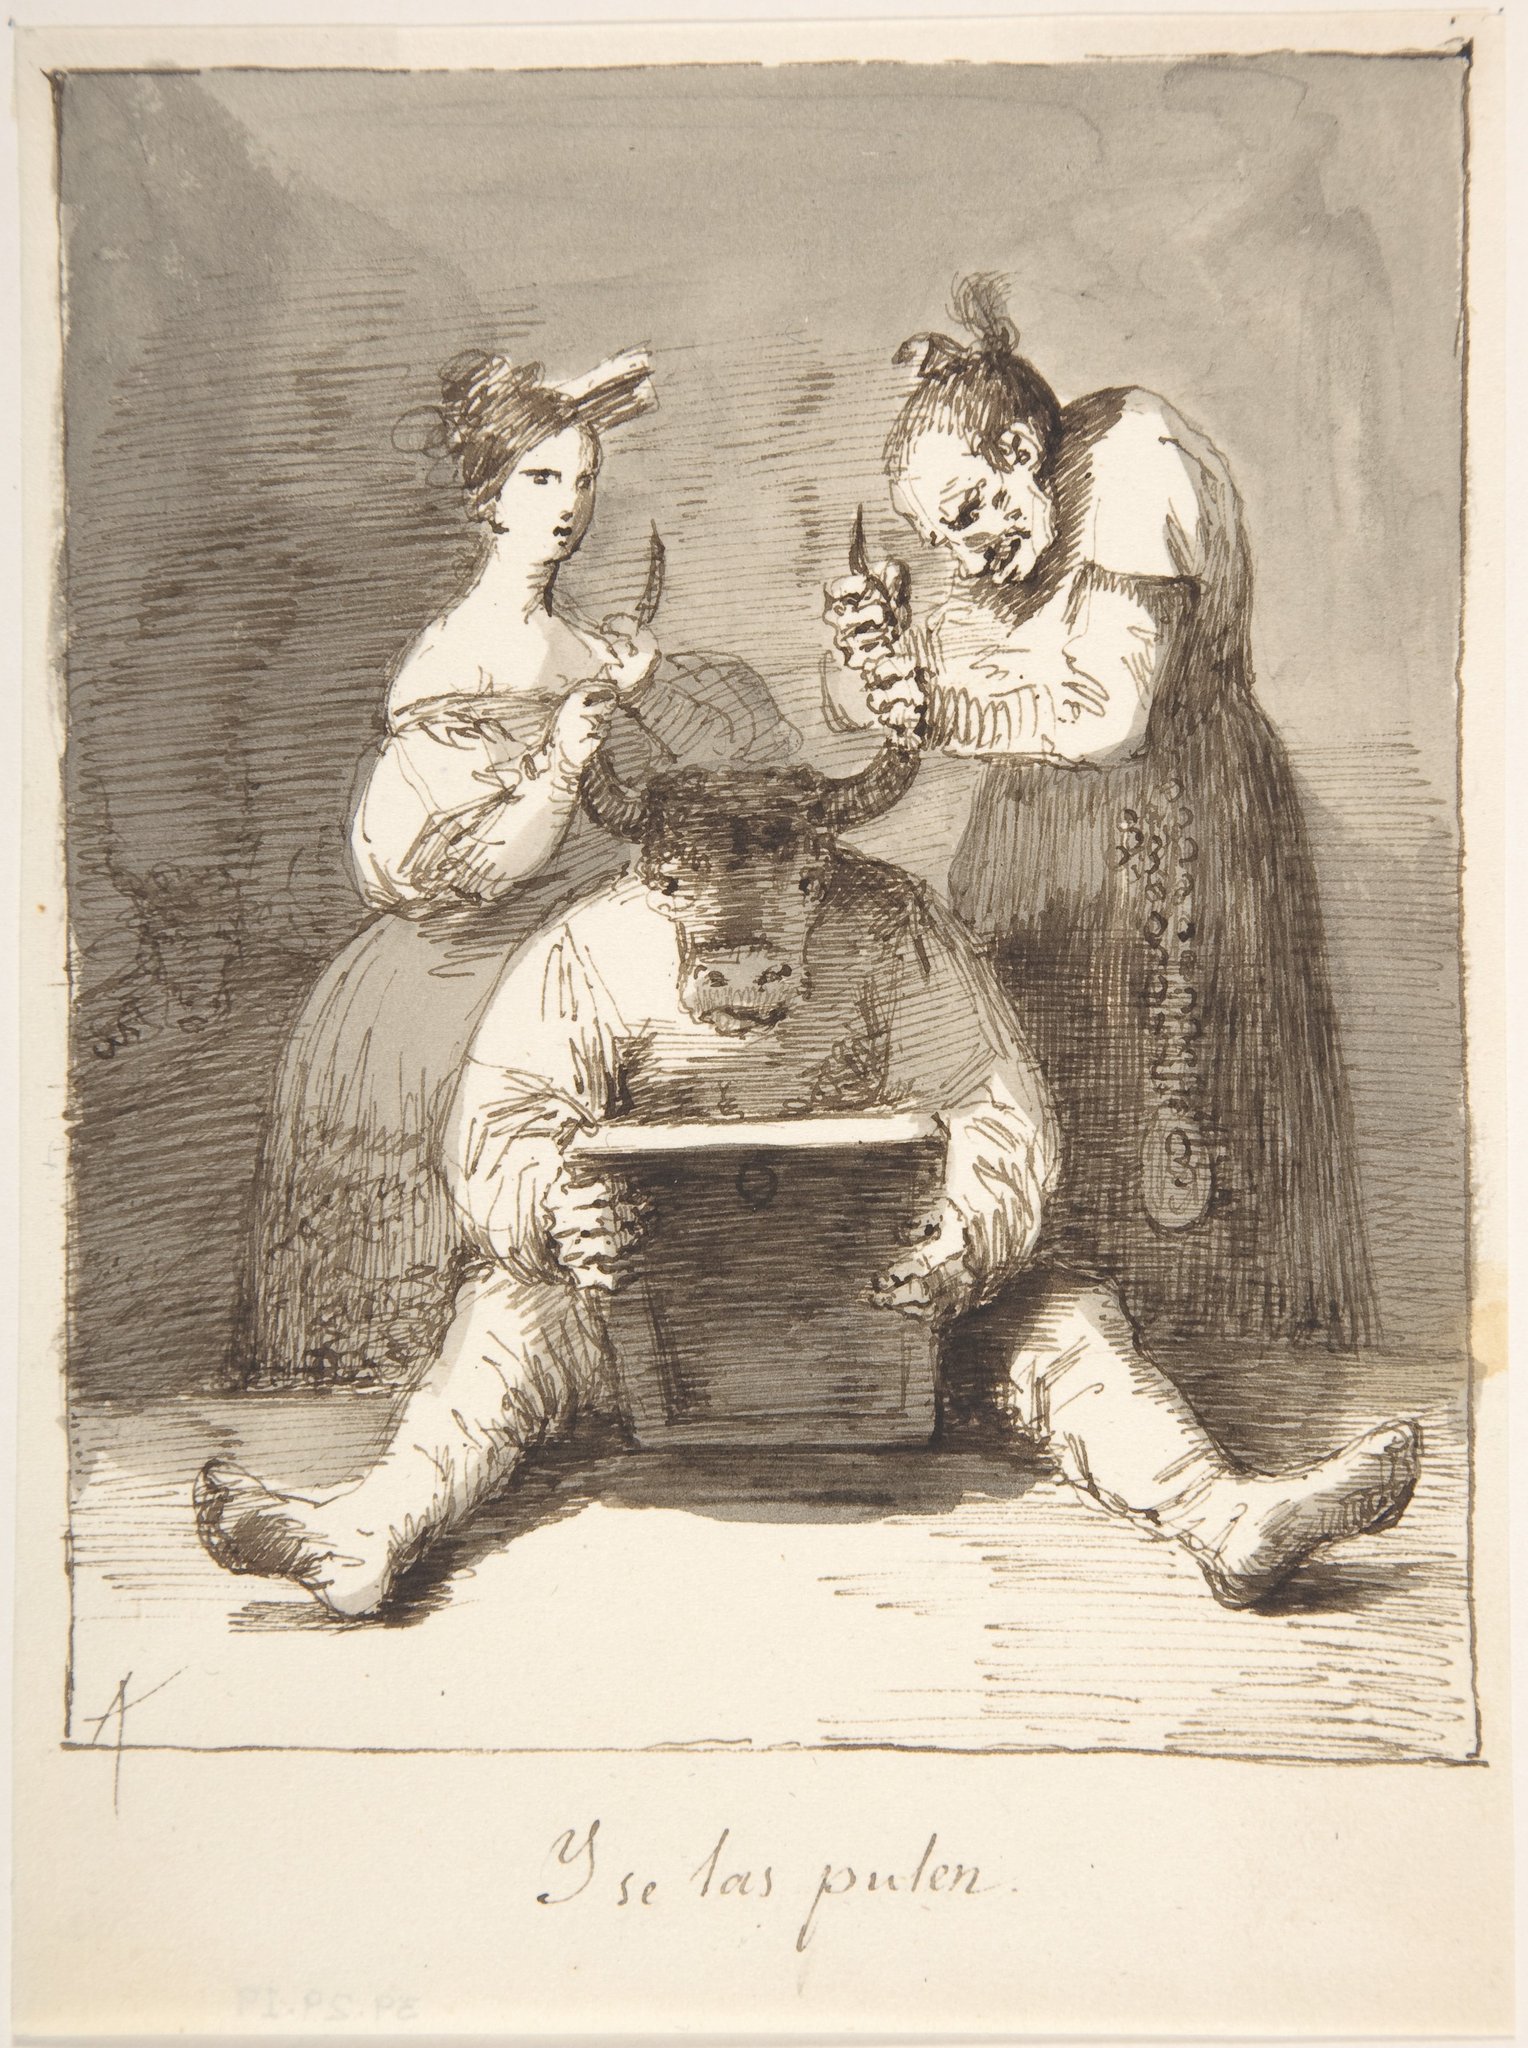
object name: drawing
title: They are Polishing Him Up (Y se las pulen)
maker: leonardo alenza y nieto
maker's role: artist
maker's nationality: spanish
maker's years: 1807-1845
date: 1807-1845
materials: chalk, ink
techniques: brush, pen, wash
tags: women,mirrors